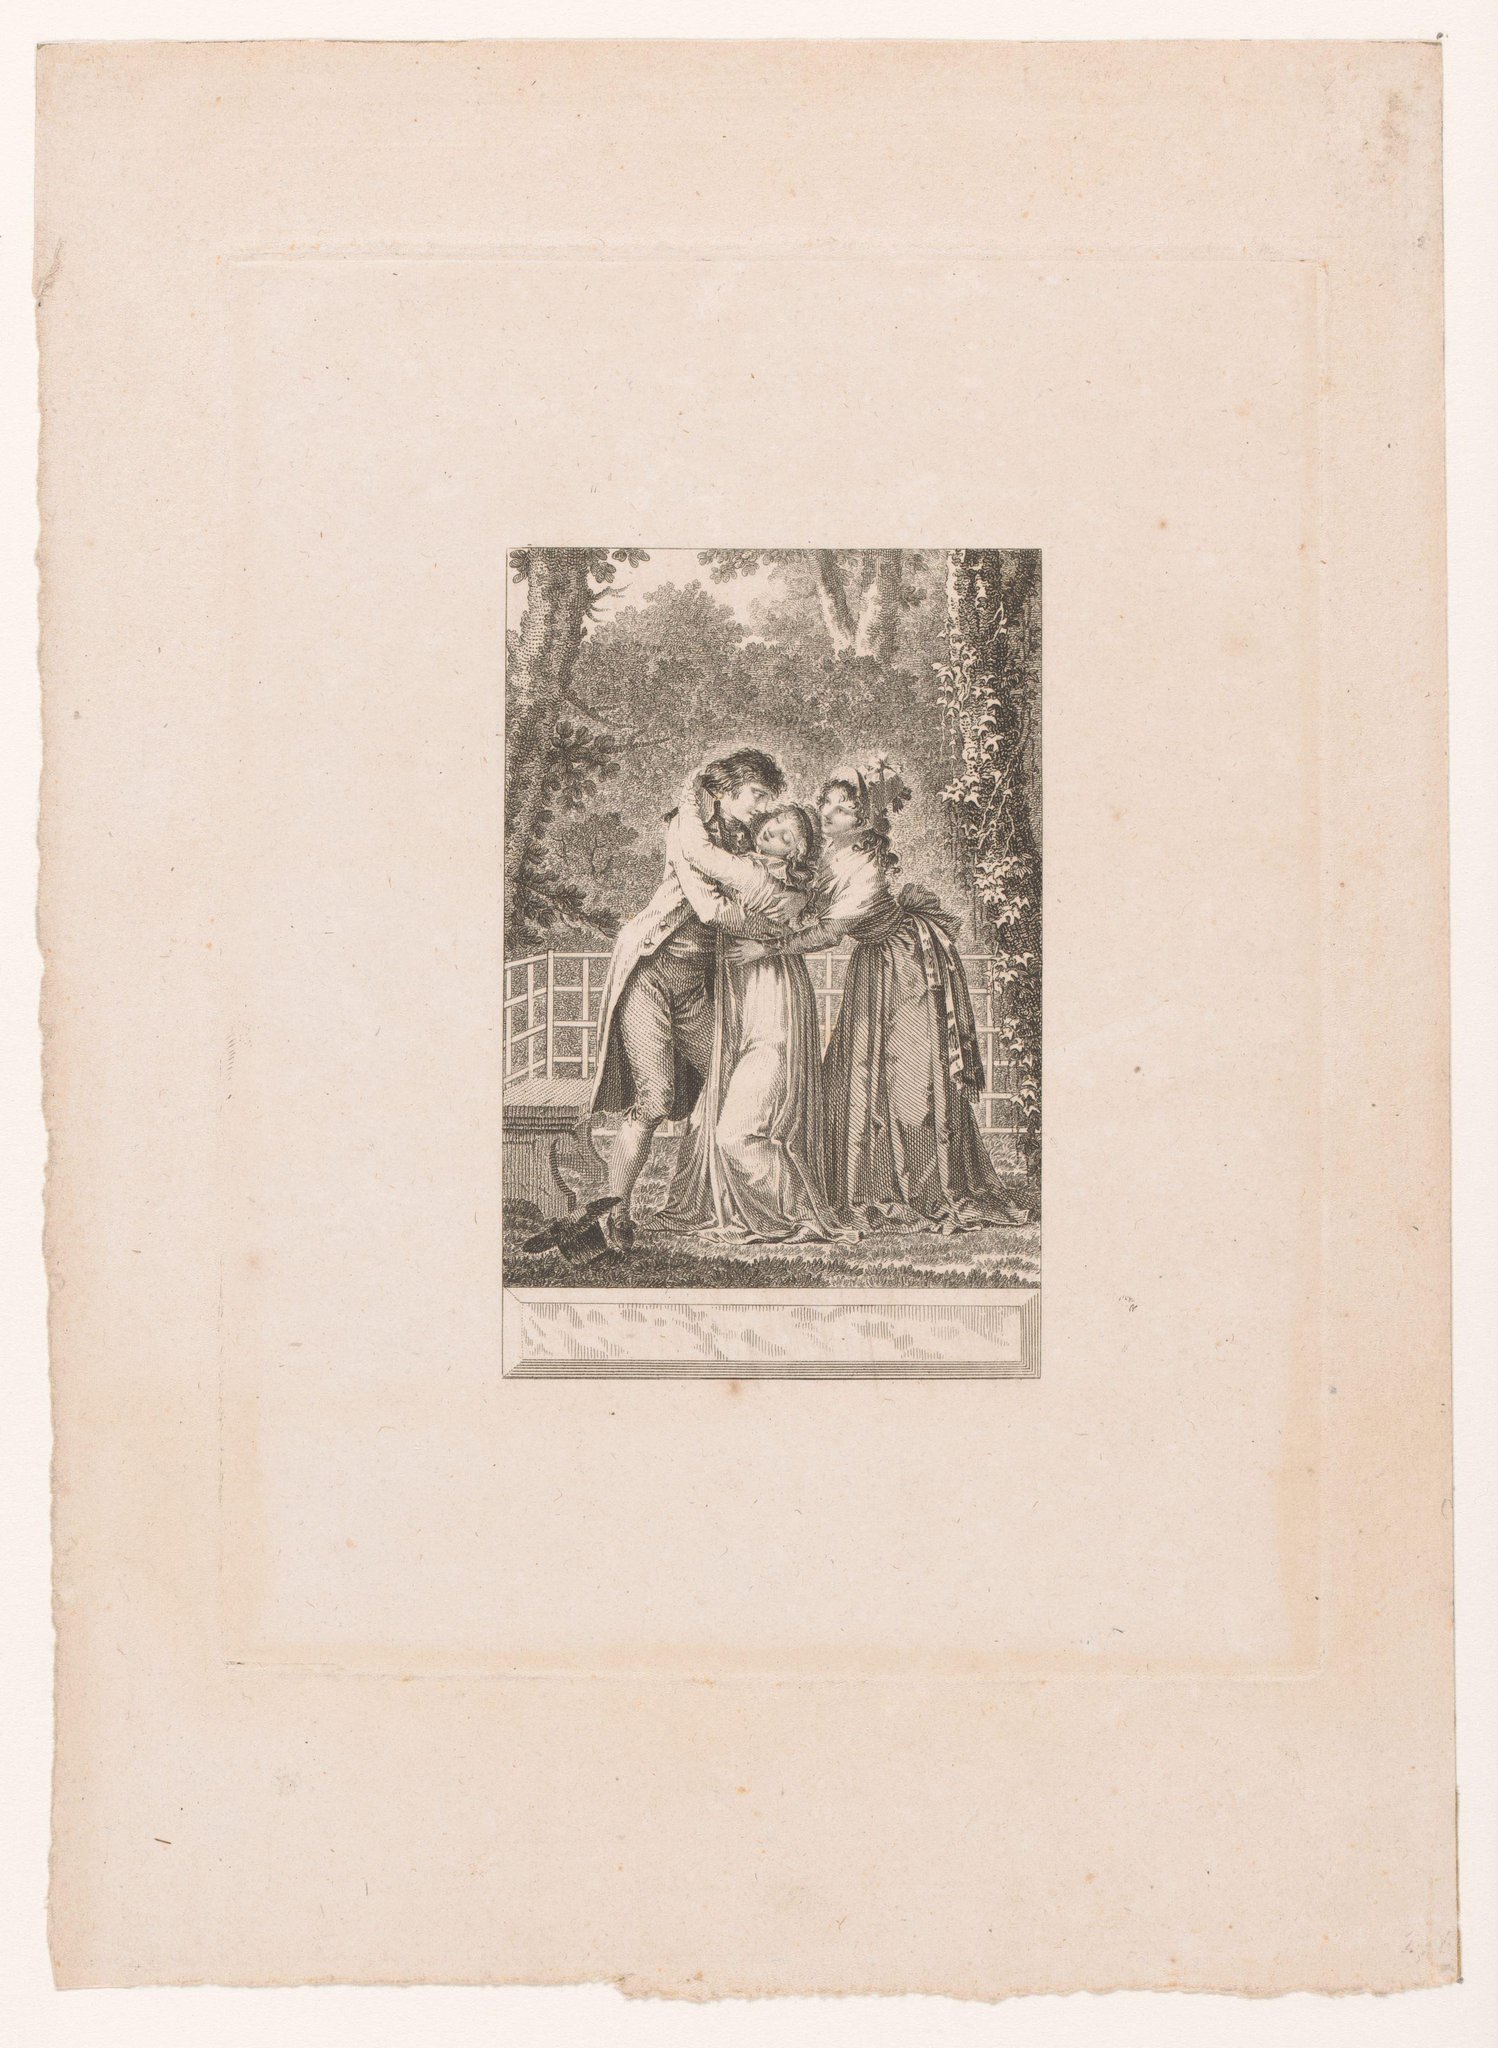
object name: book illustration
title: Eerste kus van Julie en Saint-Preux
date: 1808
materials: paper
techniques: etching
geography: paris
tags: (lovers) kissing each other, literary characters and objects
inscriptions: collector's mark: Lugt 230, collector's mark: Lugt 2228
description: Prent uit: Rousseau, Jean-Jacques. La nouvelle Heloïse (...). Parijs: Bossange, Masson & Besson e.a., 1808.